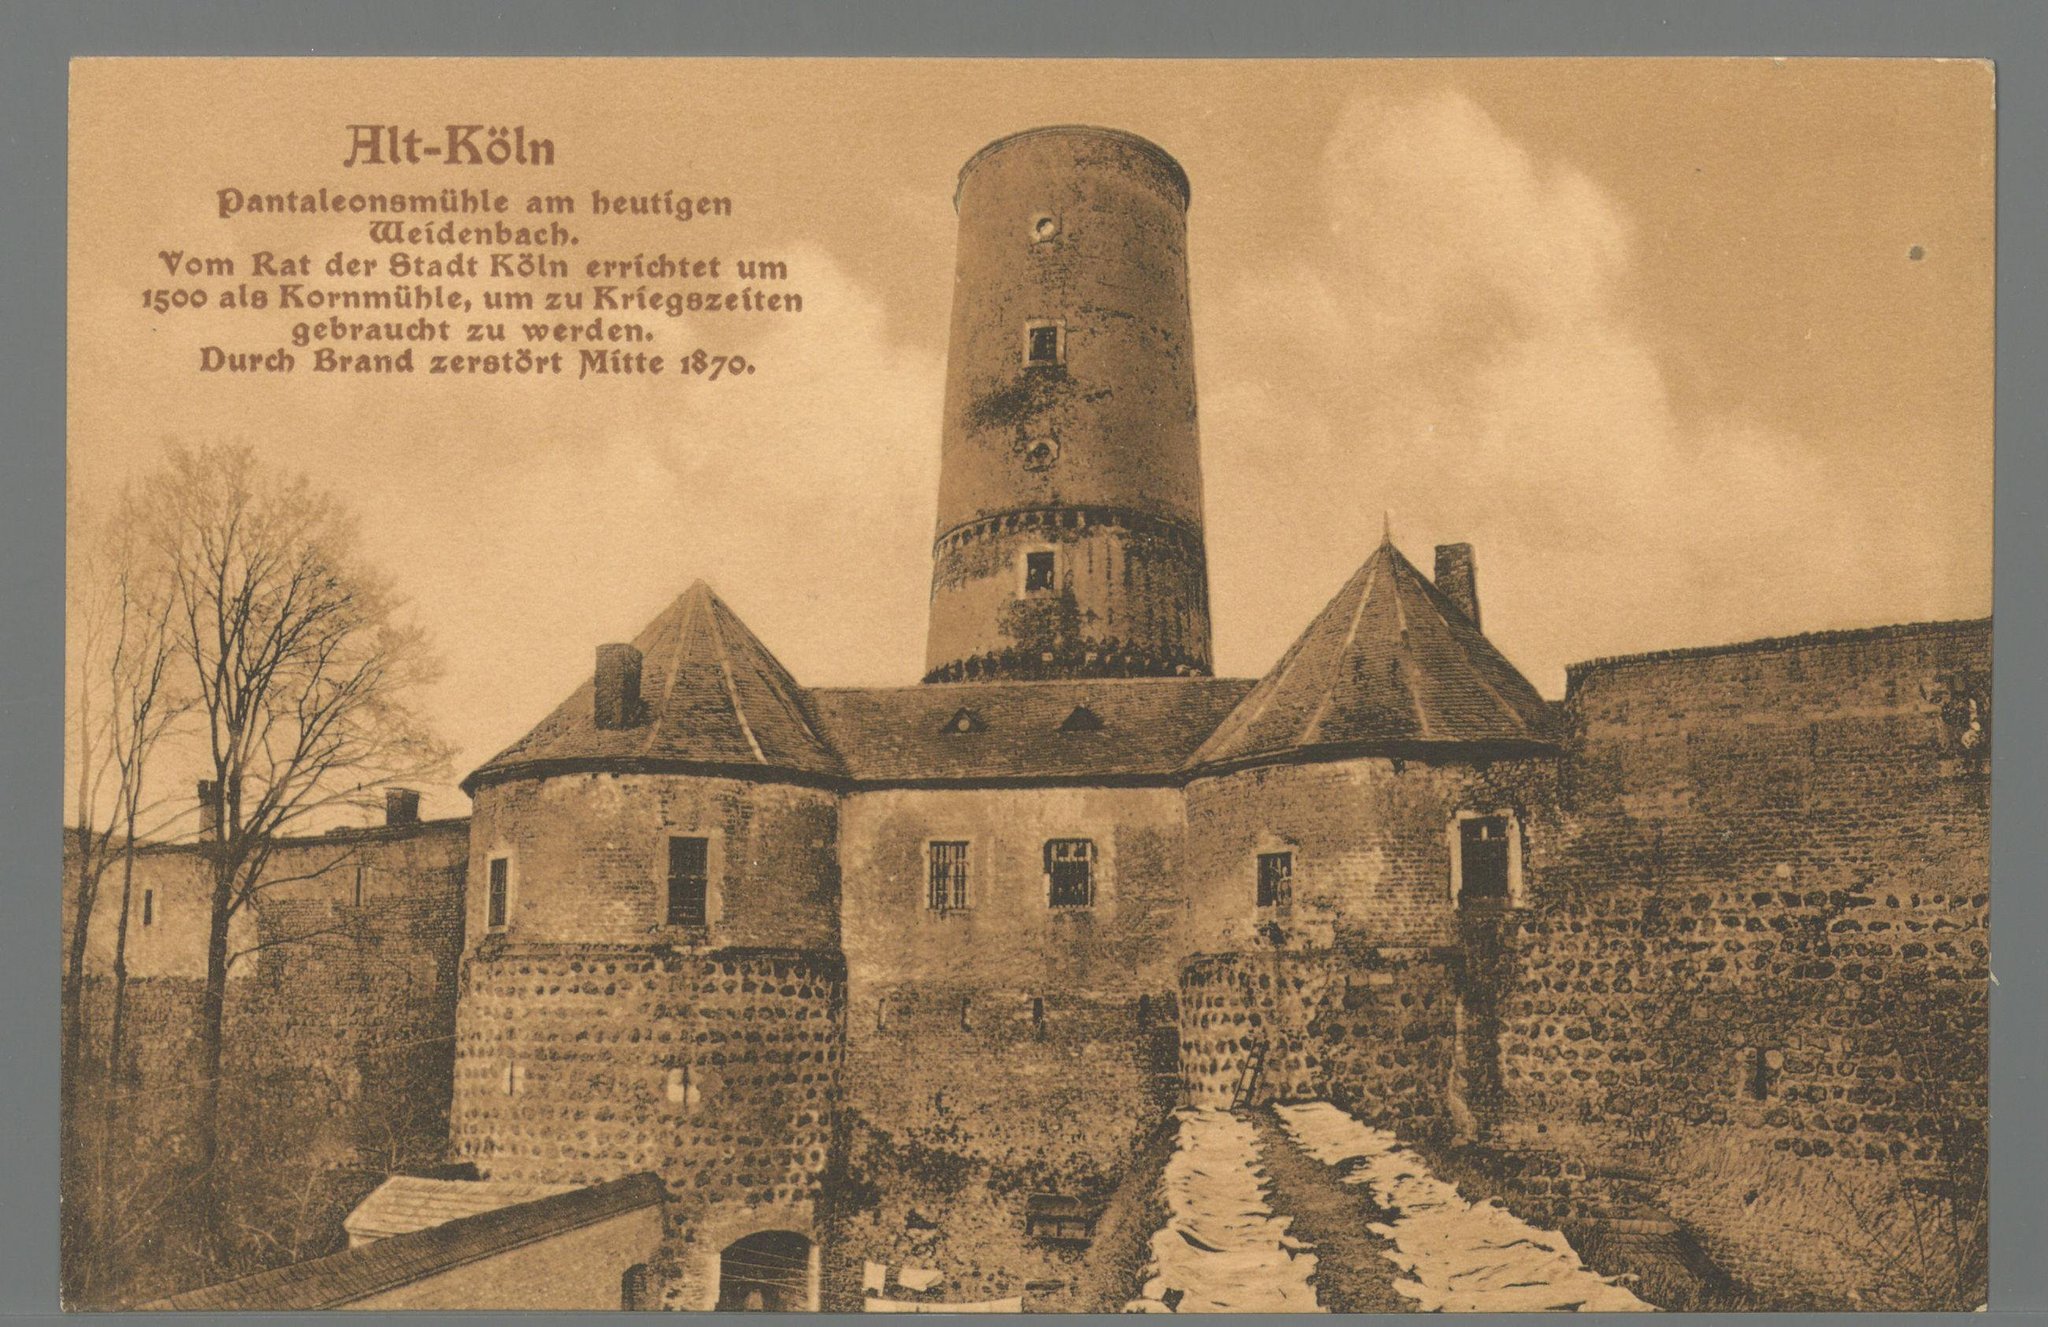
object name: photomechanical print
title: Alt-Köln. Pantaleonsmühle am heutigen Weidenbach. Vom Rat der Stadt Köln errichtet um 1500 als Kornmühle, um zu Kriegszeiten gebraucht zu werden. Durch Brand zerstört Mitte 1870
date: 1905-1920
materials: cardboard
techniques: photograph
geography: cologne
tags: windmill in landscape, city-walls, cologne